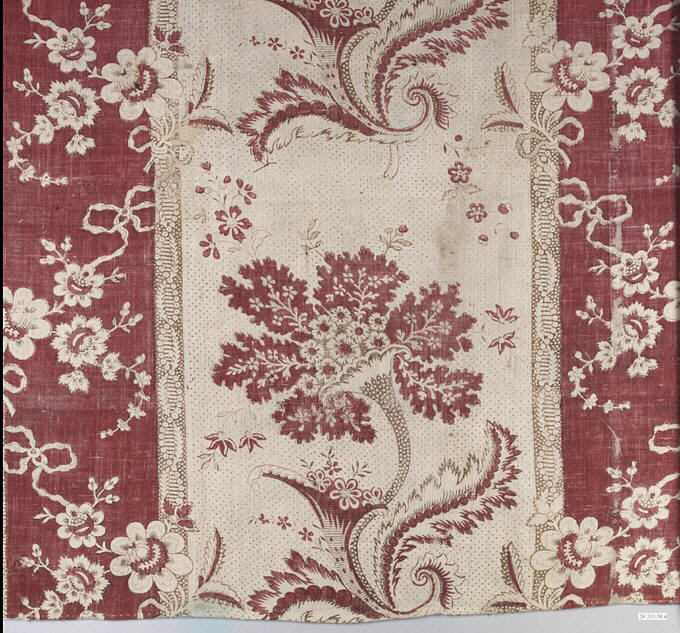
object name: floral print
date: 1788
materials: linen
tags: flowers,leaves